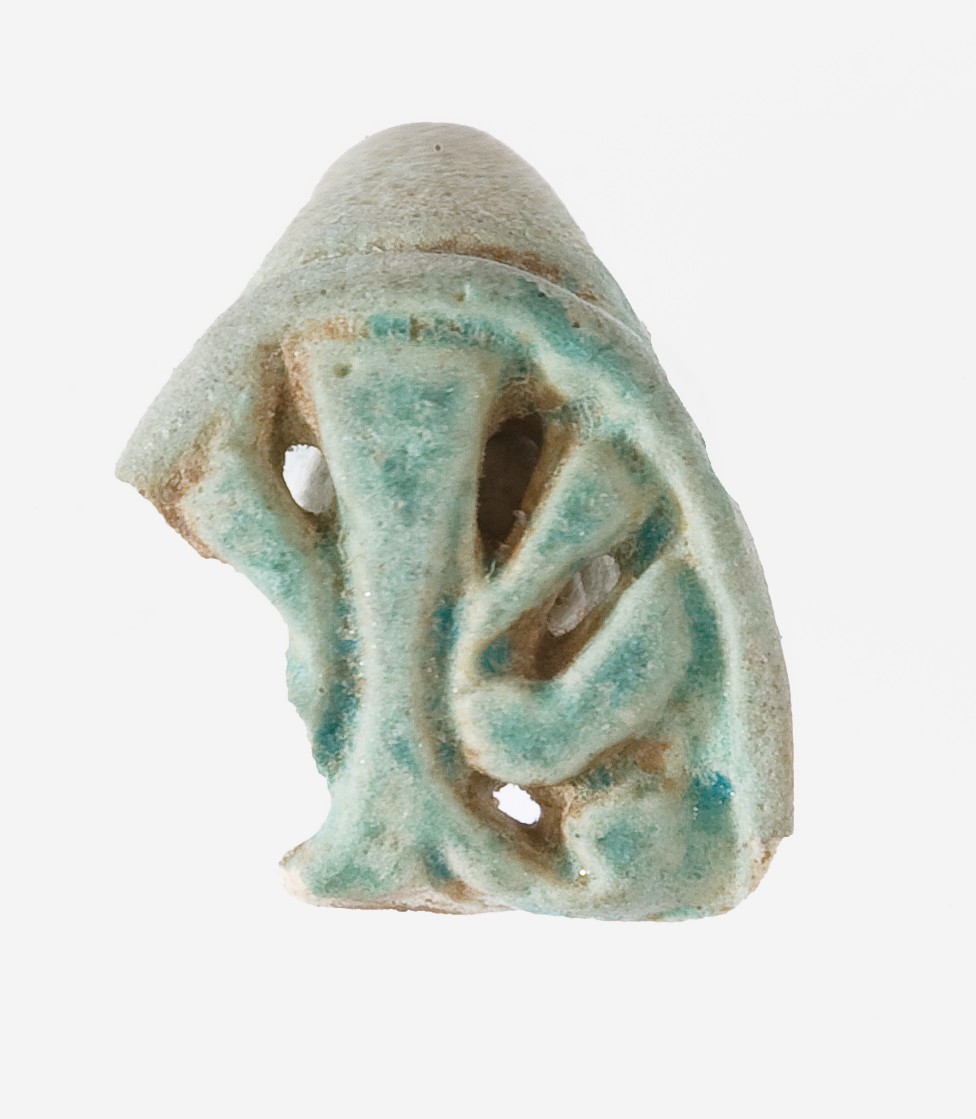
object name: ring fragment, floral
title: Ring Fragment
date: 1390-1352 BCE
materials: faience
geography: egypt